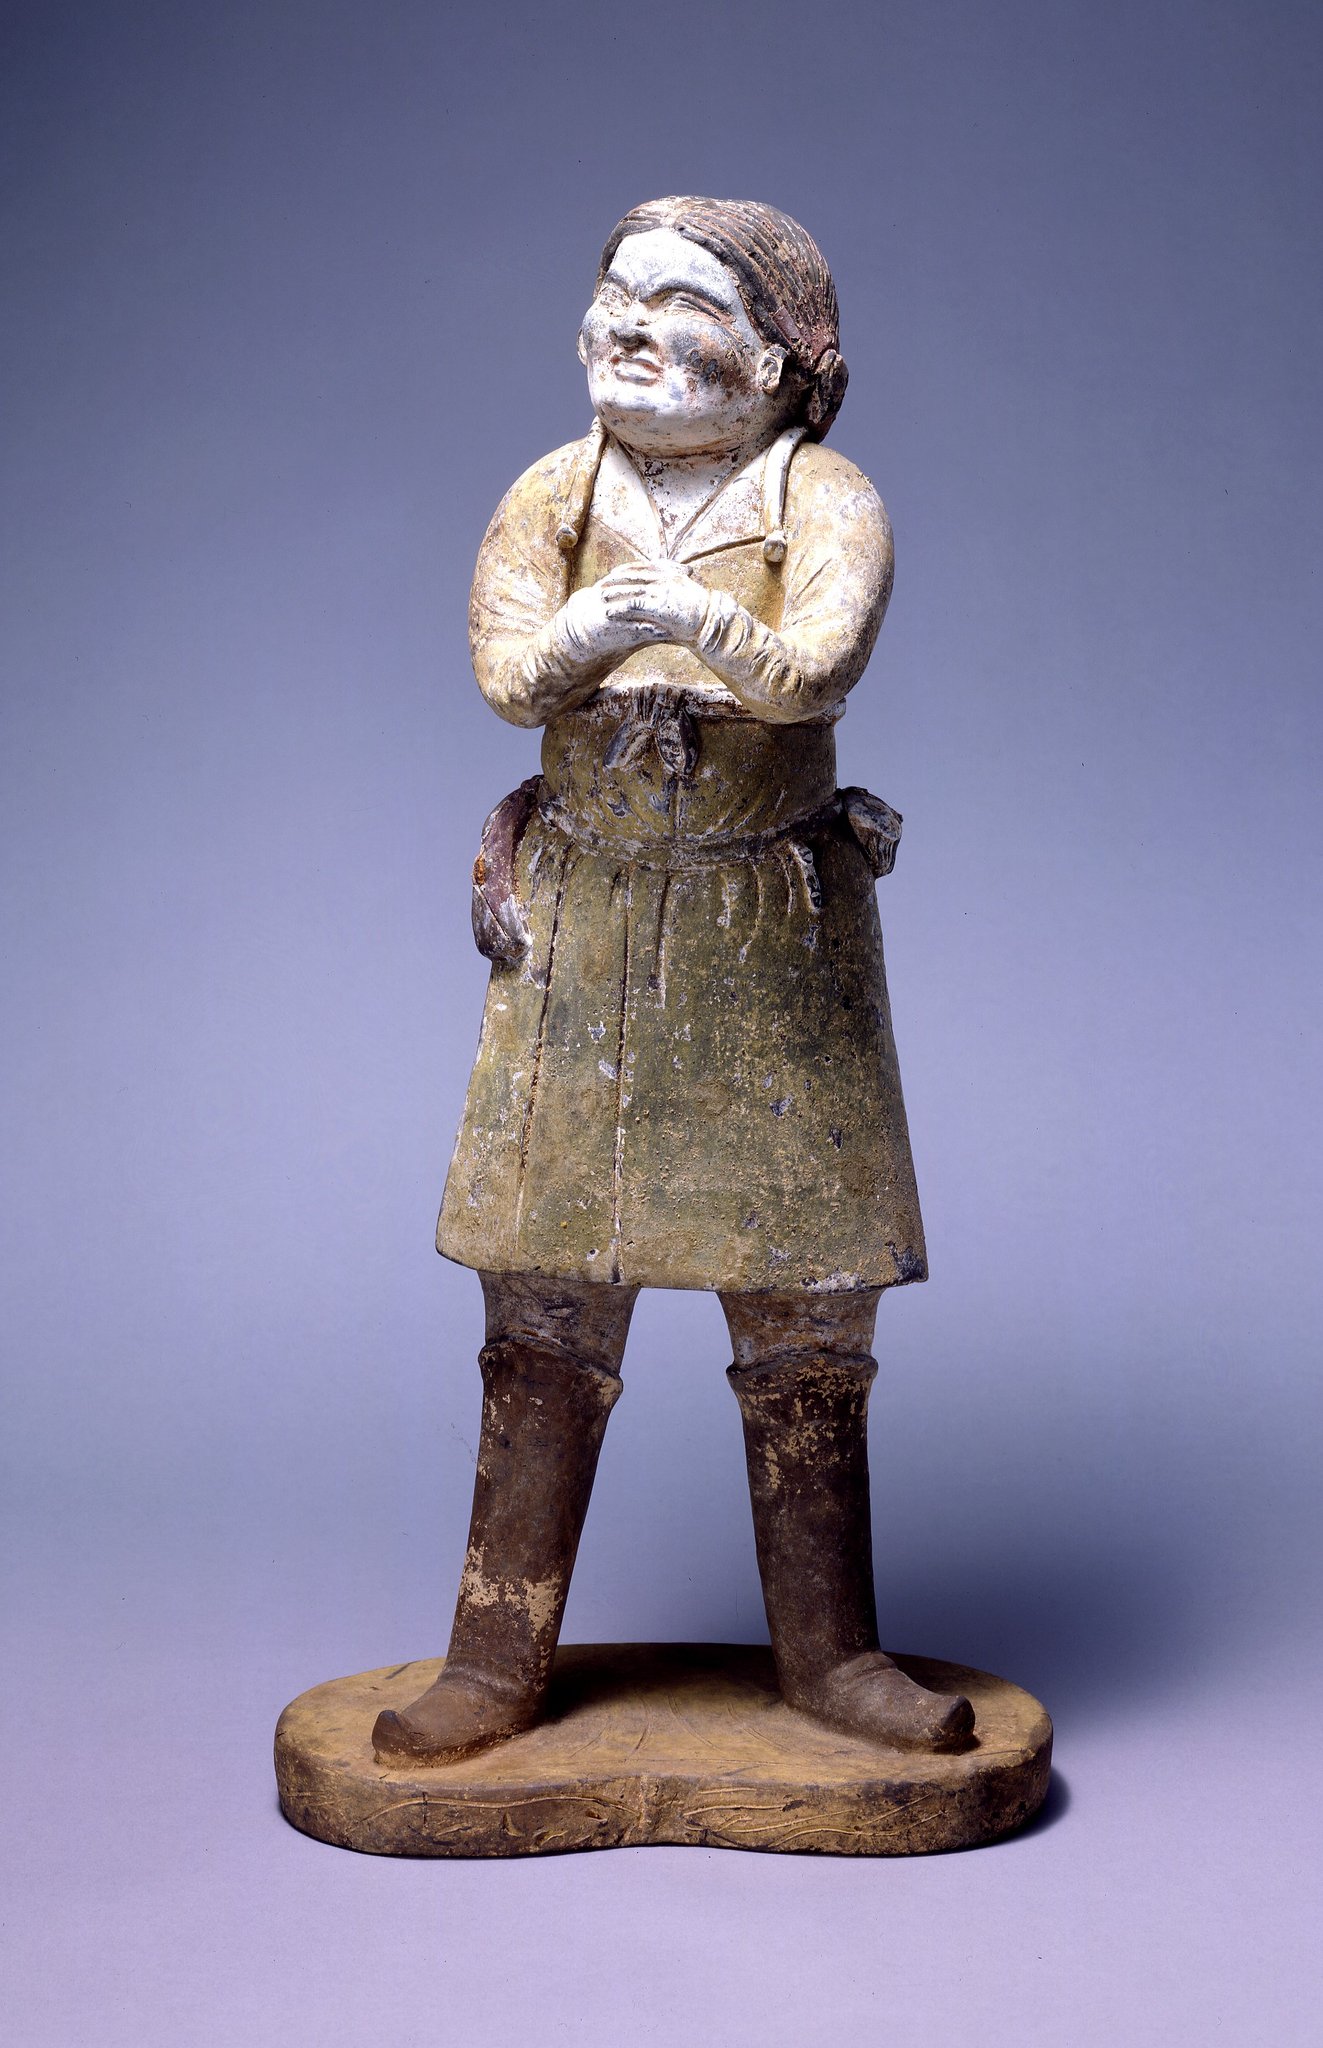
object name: figure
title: Standing attendant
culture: chinese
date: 601-700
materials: earthenware, pigment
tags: men